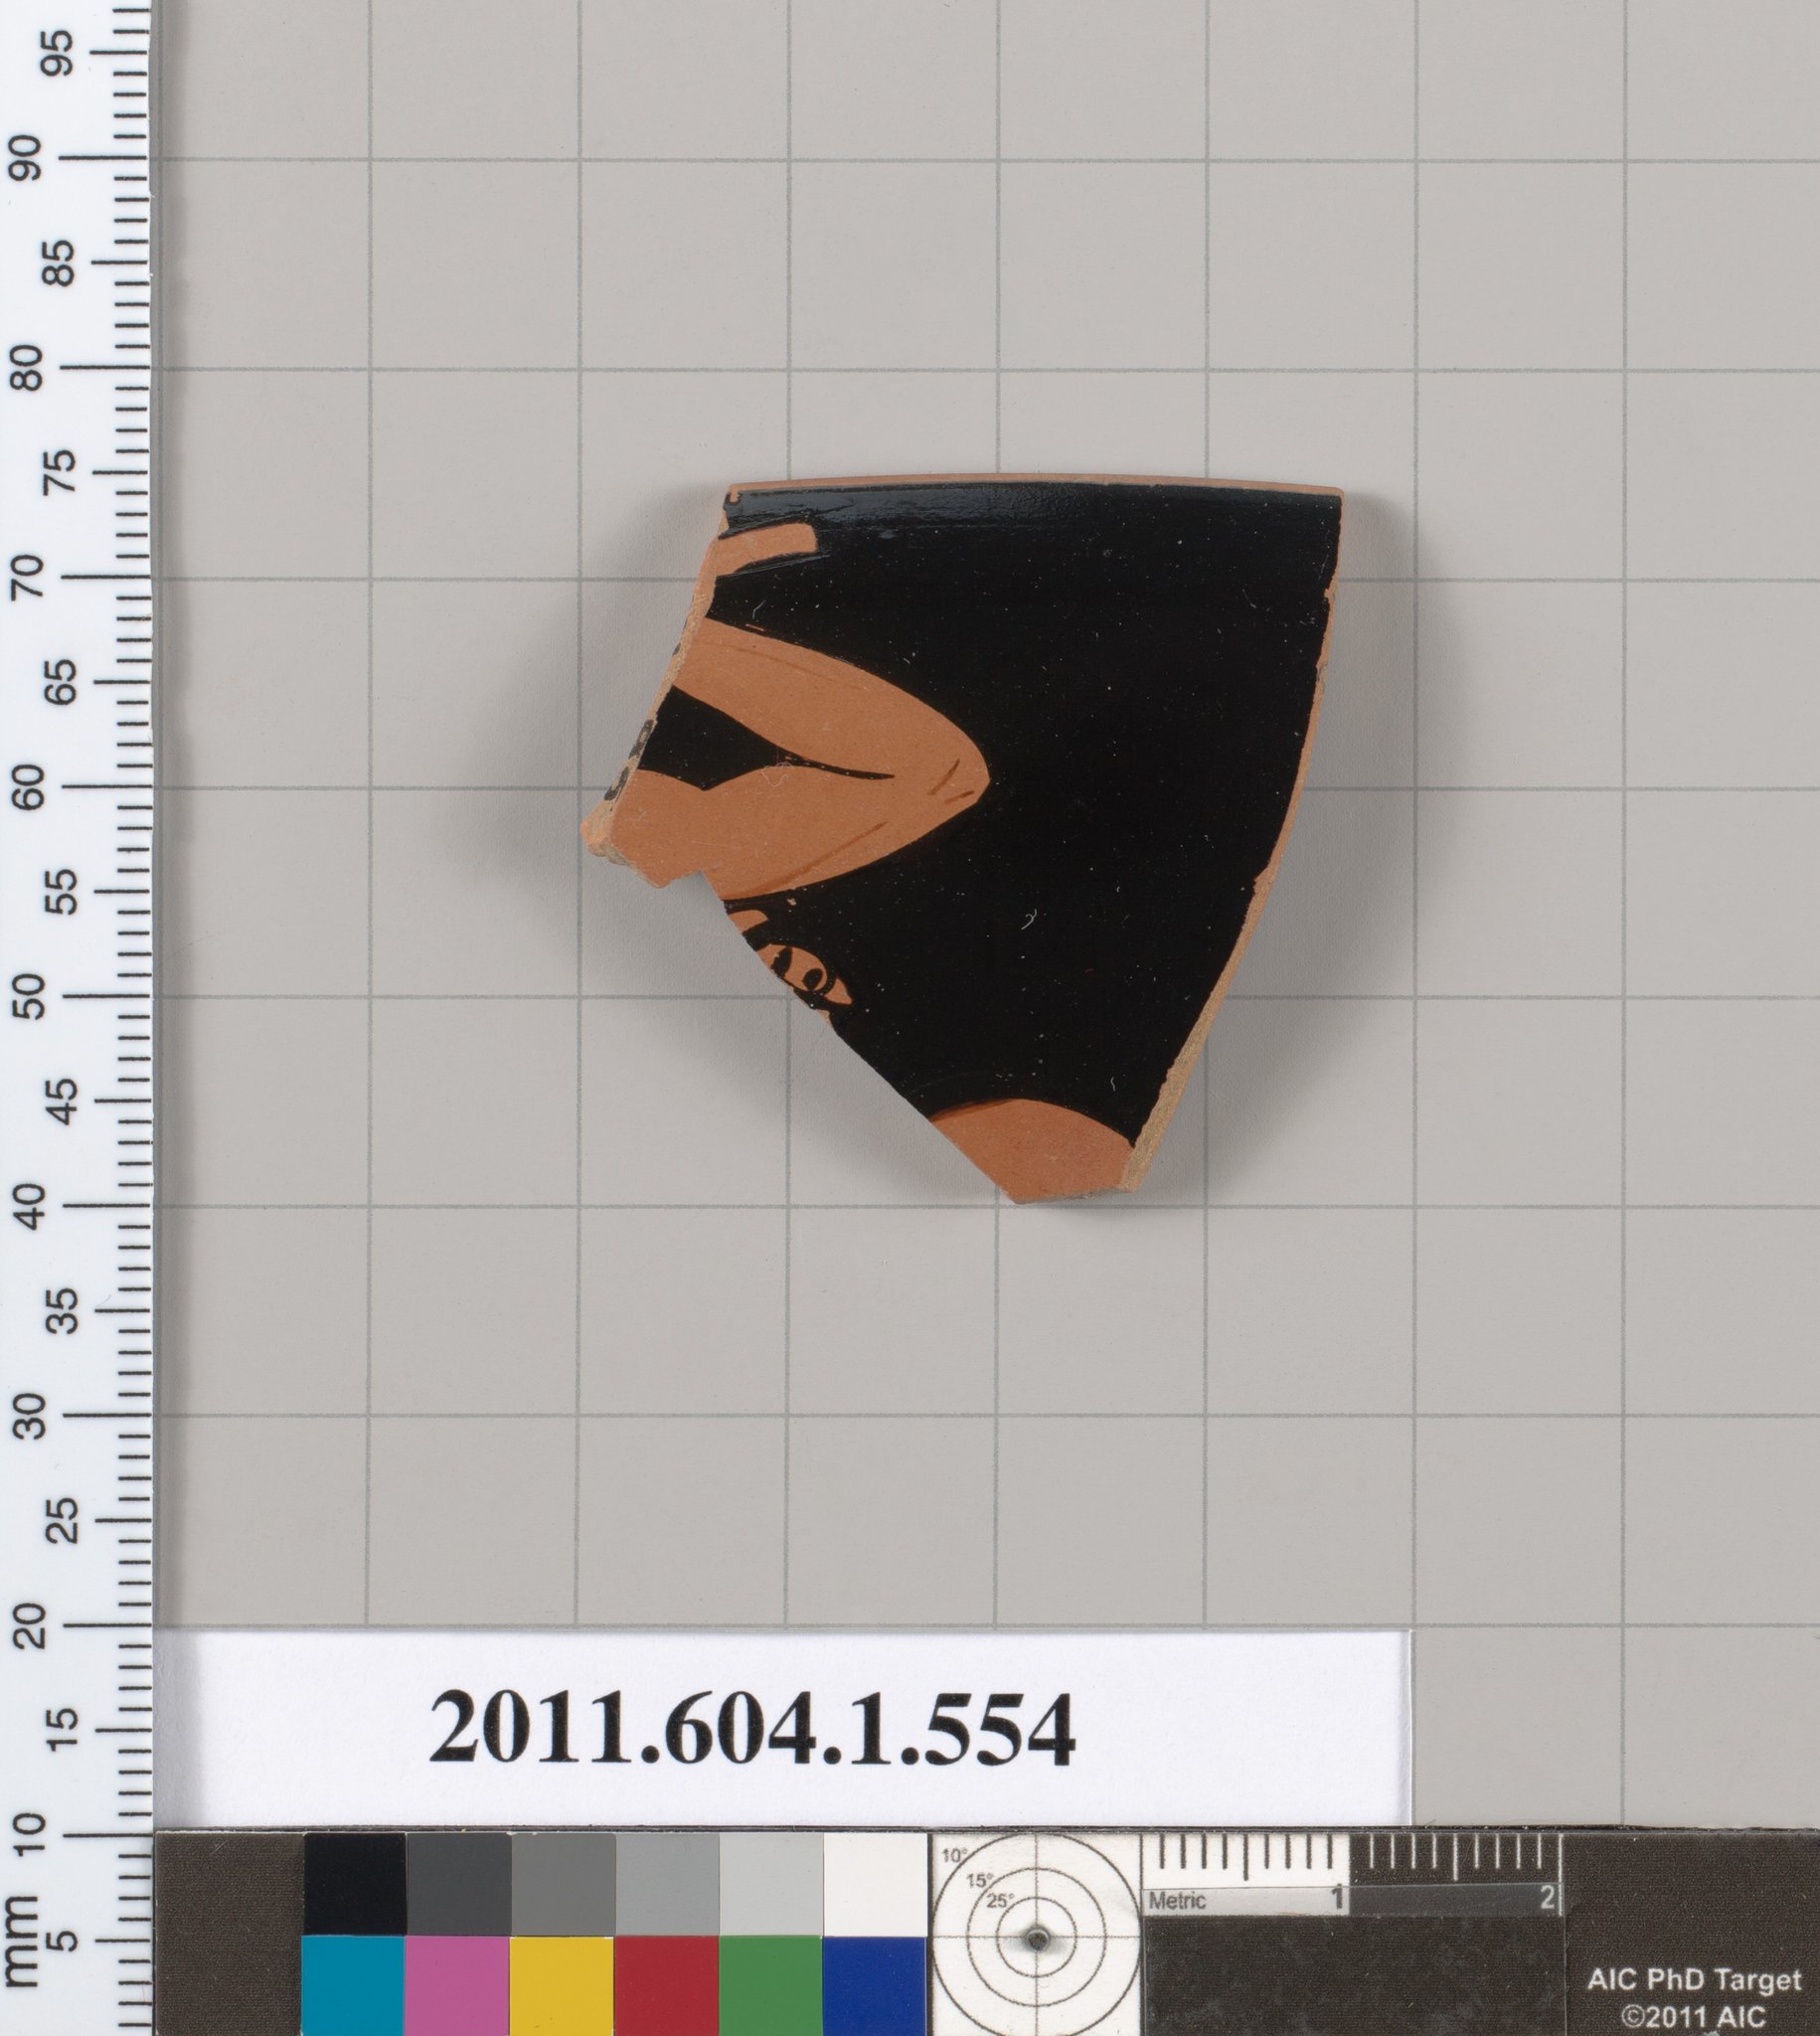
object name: kylix fragment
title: Terracotta rim fragment of a kylix (drinking cup)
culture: greek, attic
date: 480-470 BCE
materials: terracotta